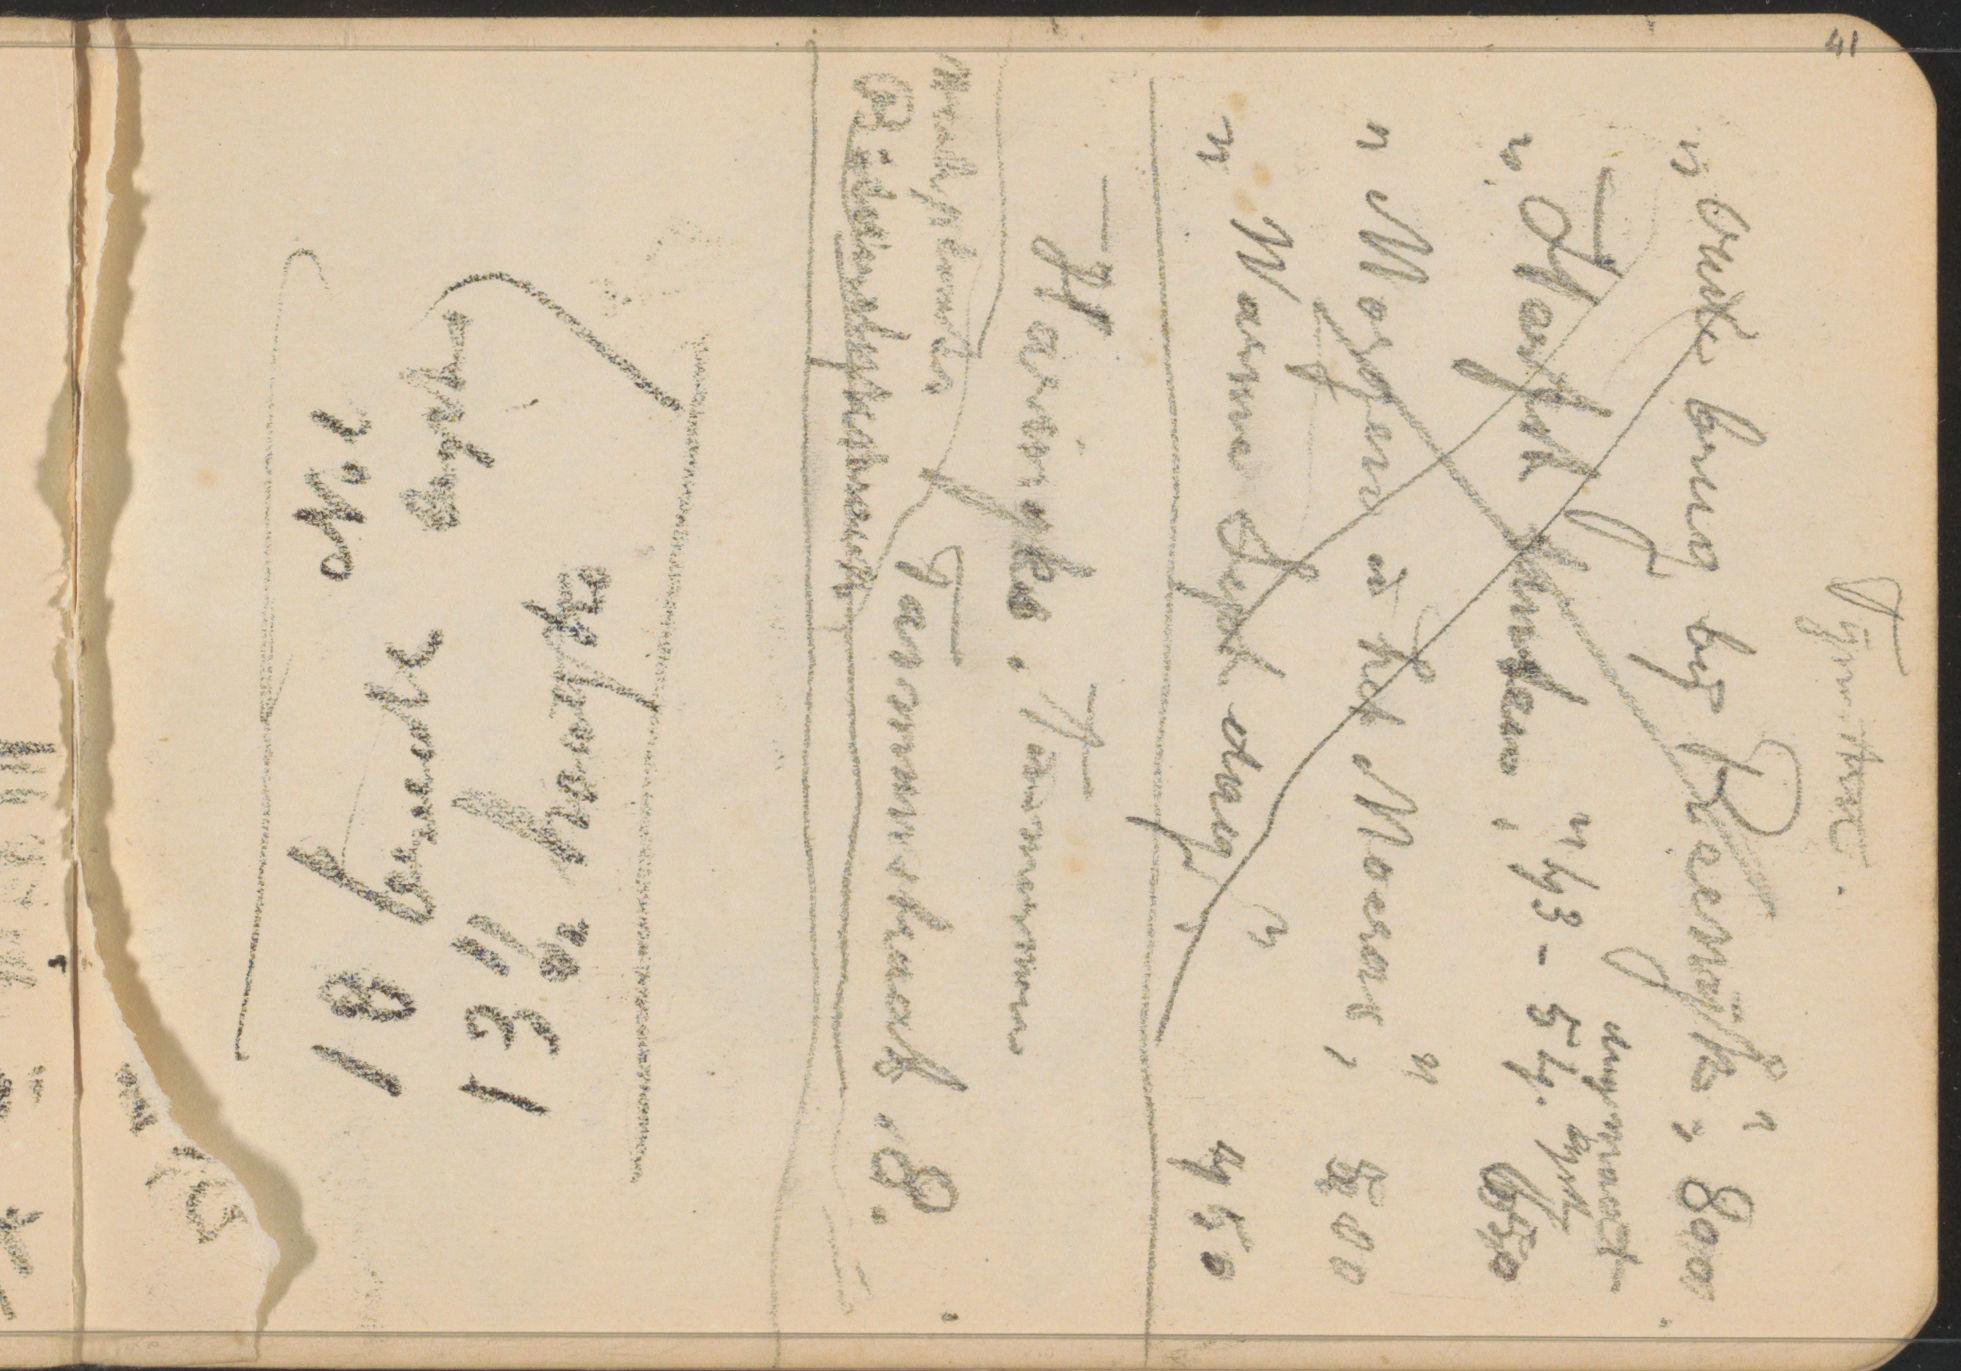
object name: sketchbook leaf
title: Notities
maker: willem cornelis rip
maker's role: draughtsman, painter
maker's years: 1856-1922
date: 1914-1916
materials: chalk, paper, pencil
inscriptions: annotation: ‘Tij[...]/ ''oude brug bij Reewijk'', 800/ ''Herfst [...]in[...]e[...] ''43-54 dagmaat/ lijst 650/ ''Morgen in het Moeras'', 500/ ''Warme Sept dag'', 450/ [...]’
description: Blad 41 recto uit een schetsboek met 41 bladen.